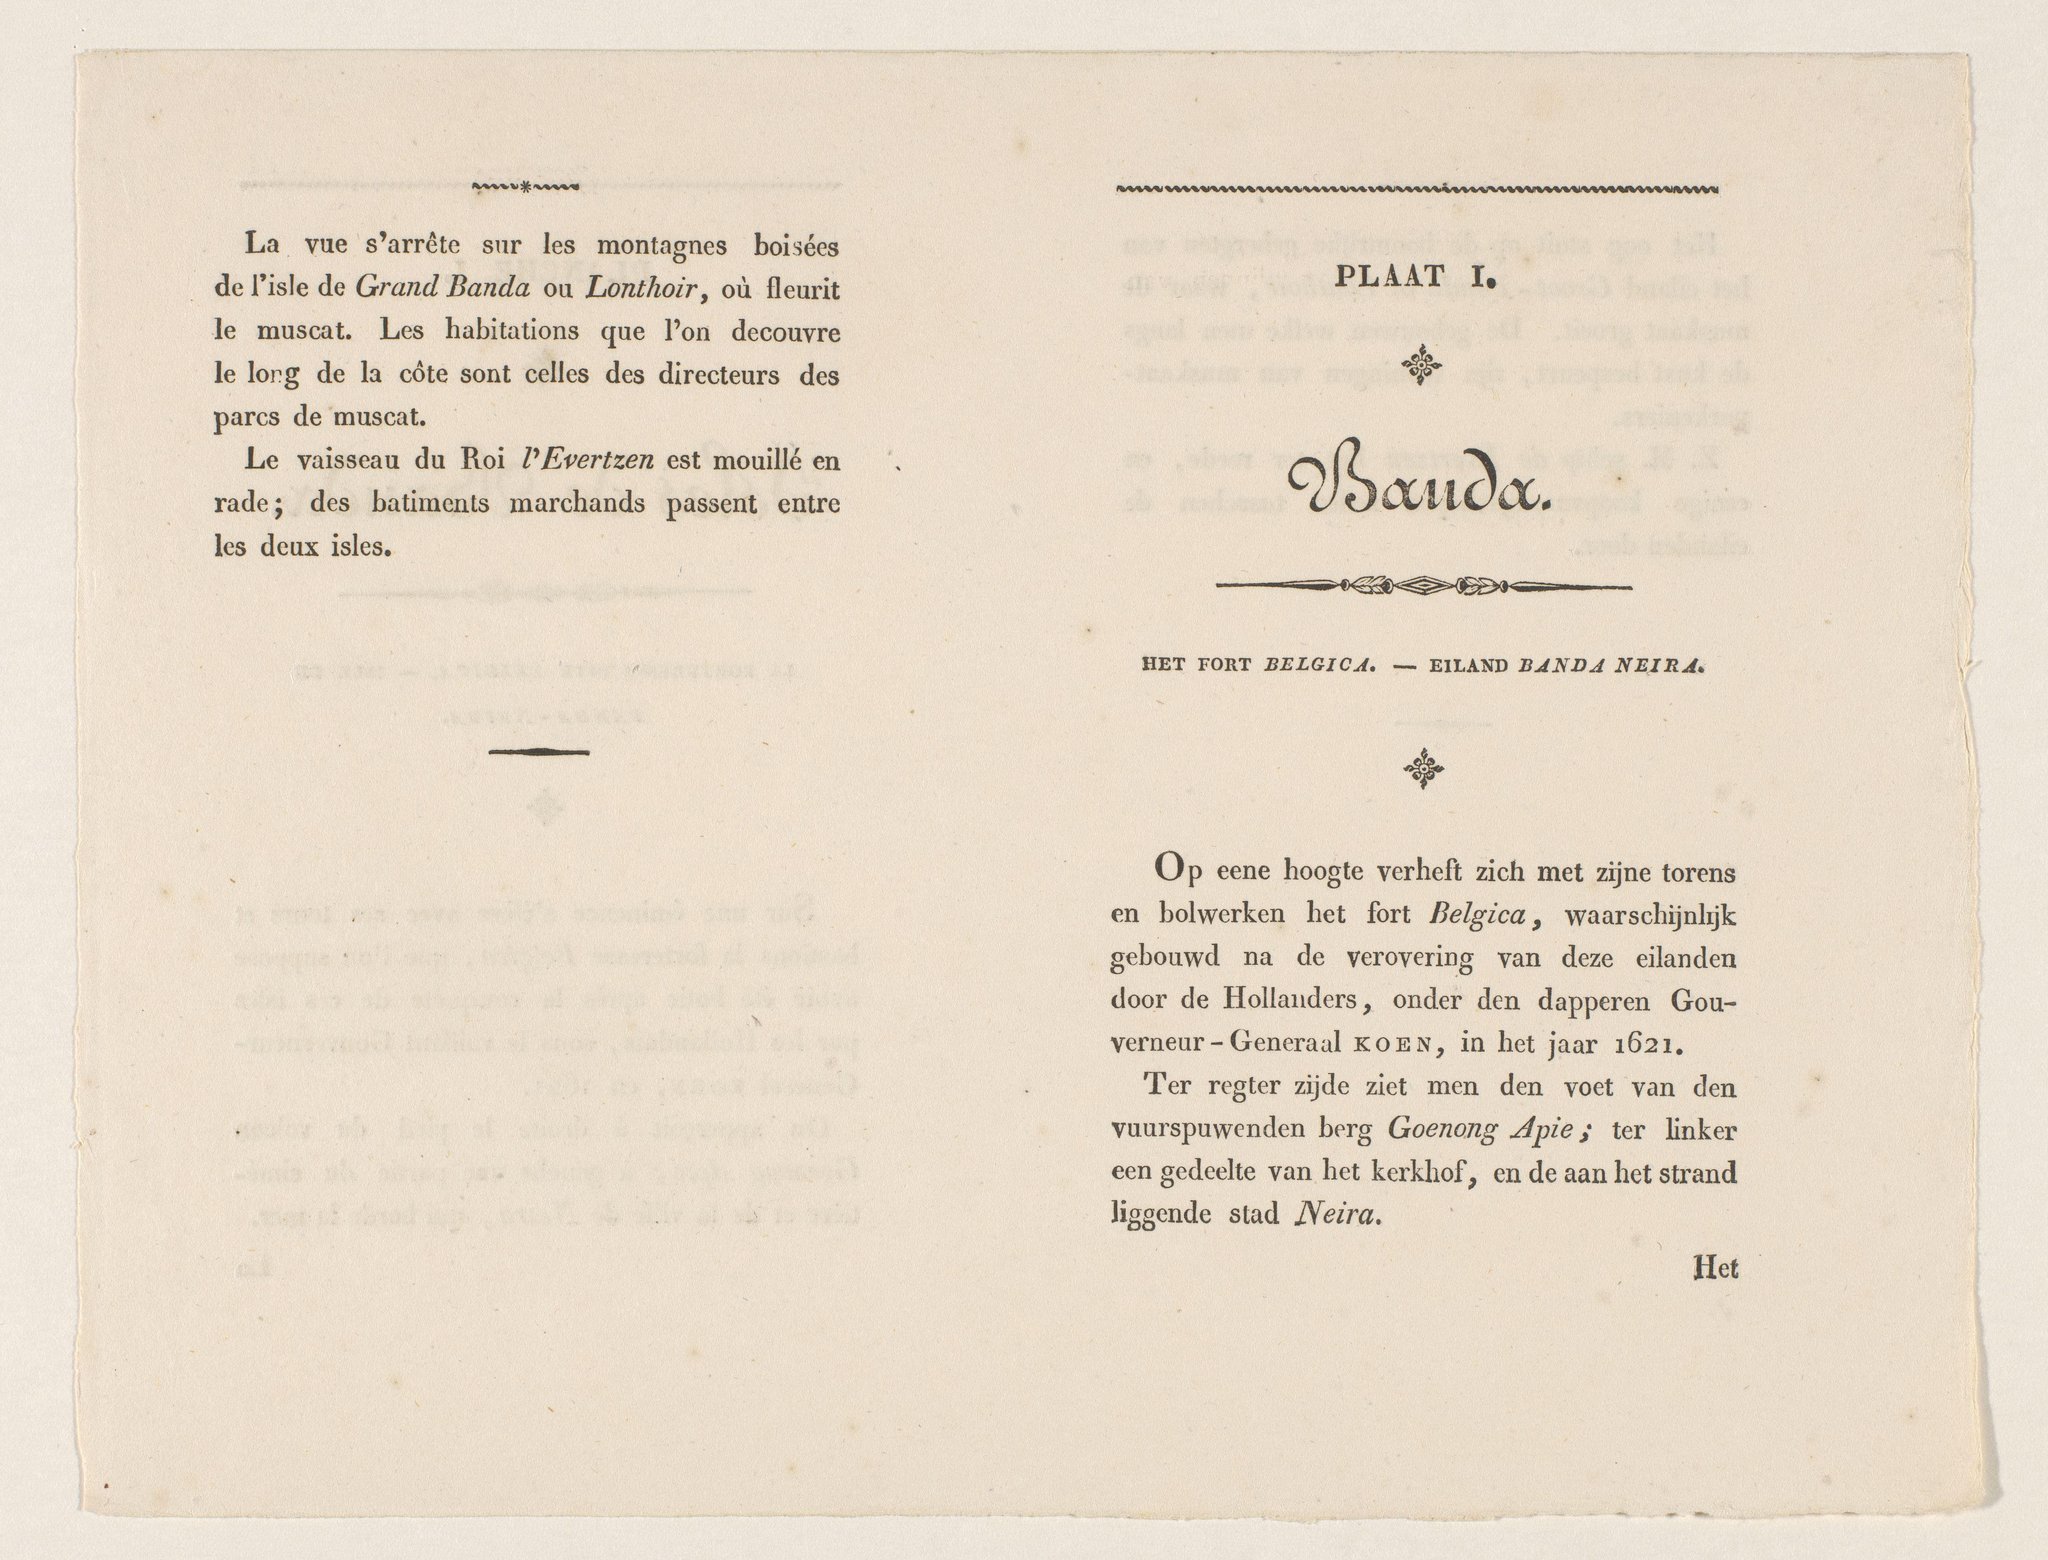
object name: text sheet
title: Landschappen in Indonesië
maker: jean baptiste ambroise marcellin jobard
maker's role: print maker, publisher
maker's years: 1792-1861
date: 1824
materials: paper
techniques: letterpress printing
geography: rotterdam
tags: fortress